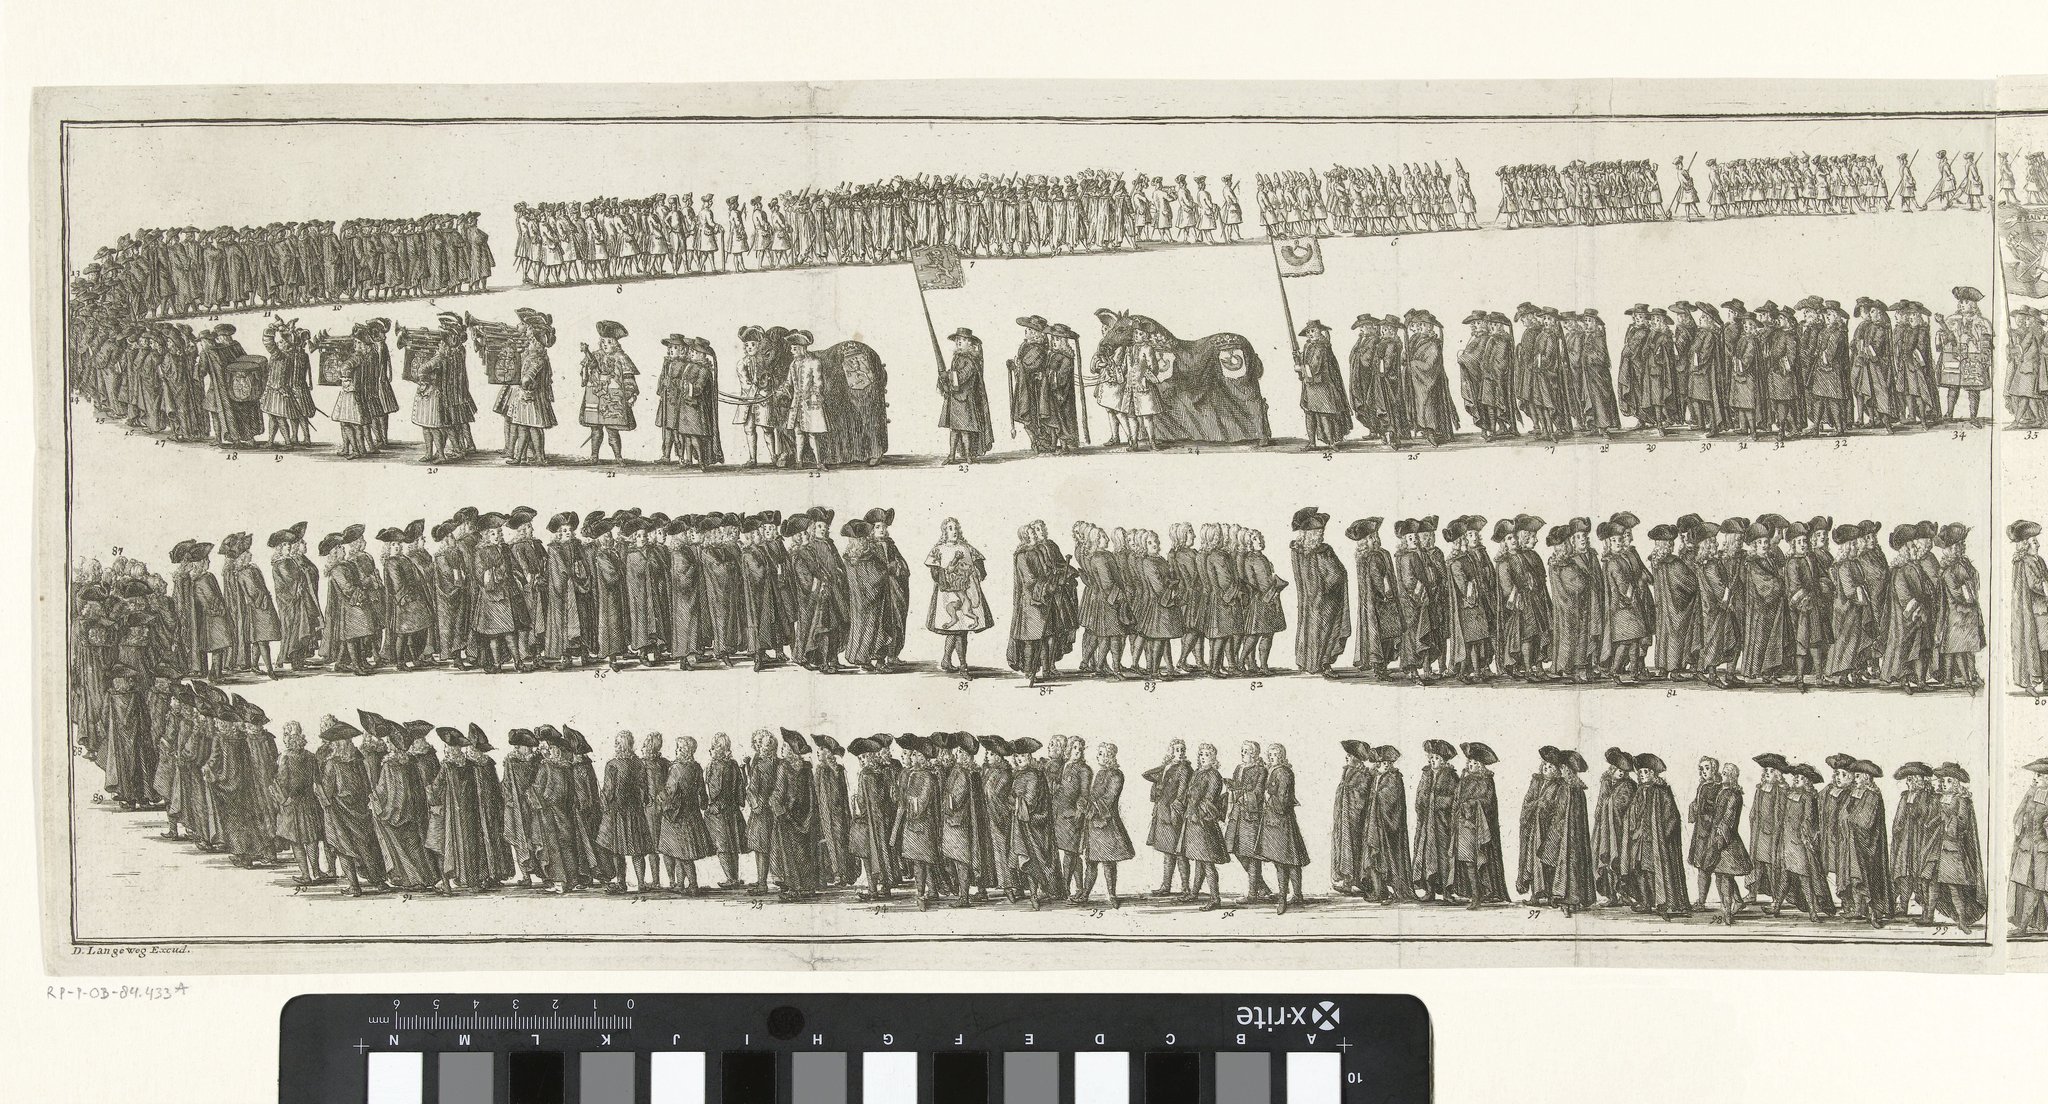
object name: print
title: Begrafenisstoet van Willem IV (linkerblad), 1752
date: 1752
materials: paper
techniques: etching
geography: northern netherlands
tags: the hague, willem iv (prins van oranje-nassau), cortege, funeral procession, delft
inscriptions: collector's mark: Lugt 2228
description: Nummer FMH 4038A zit niet in Frederik Muller, het is een later door het RPK toegevoegd nummer. Mogelijk zijn deze twee lossen afdrukken de plaat die door Muller onder FMH 4034b wordt beschreven, al vermeldt hij daar dat de platen aaneengevoegd zijn. Als dit het geval is dan behoren de hierbij vermelde losse bladen met de beschrijving (RP-P-OB-84.425) bij deze prenten.